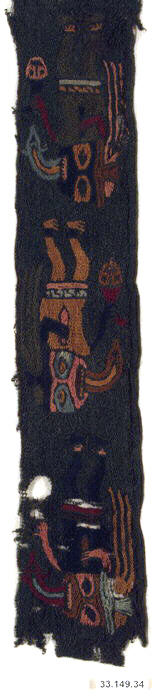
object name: border fragment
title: Embroidered Border Fragment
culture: paracas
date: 400-201 BCE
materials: animal fiber, cotton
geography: peru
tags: human figures